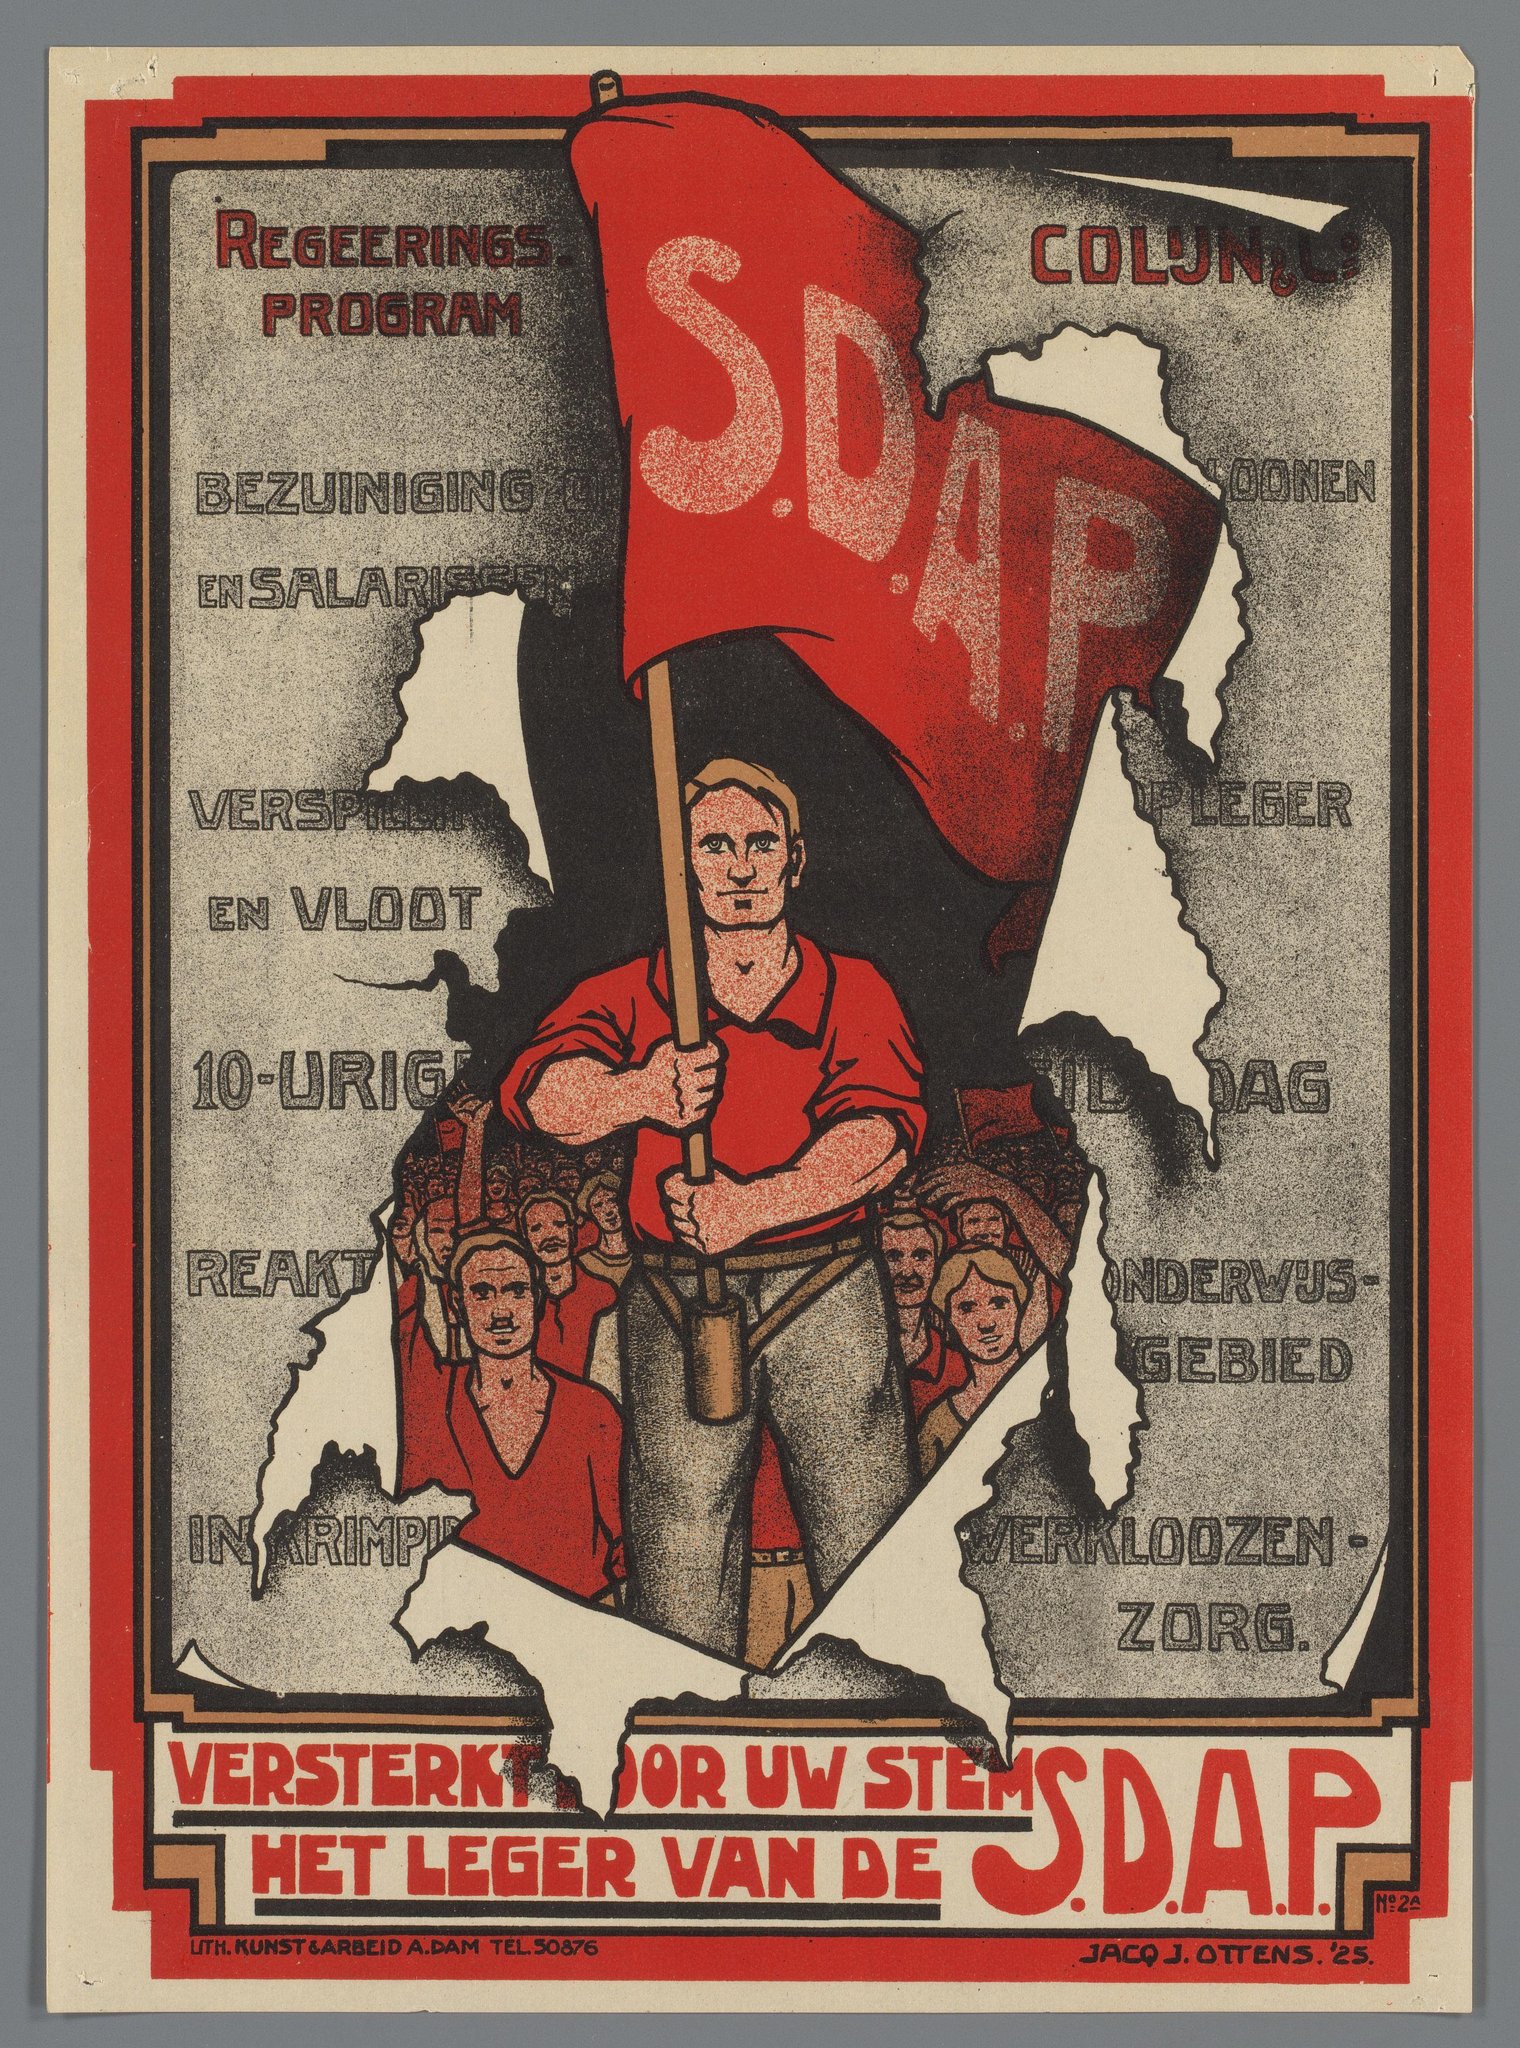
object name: poster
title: Versterkt door Uw stem het leger van de S.D.A.P.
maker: jacques jeichienus ottens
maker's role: print maker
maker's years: 1895-1930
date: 1925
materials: paper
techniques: lithograph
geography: netherlands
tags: political demonstration, working class, labourers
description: Affiche met oproep voor steun aan de politieke partij SDAP. Arbeider met vlag van de SDAP leidt een optocht van medestanders. Zij doorbreken de papieren muur van het 'Regeerings-Progream' van 'Colijn & Co.'. Genummerd rechtsonder: No. 2A.